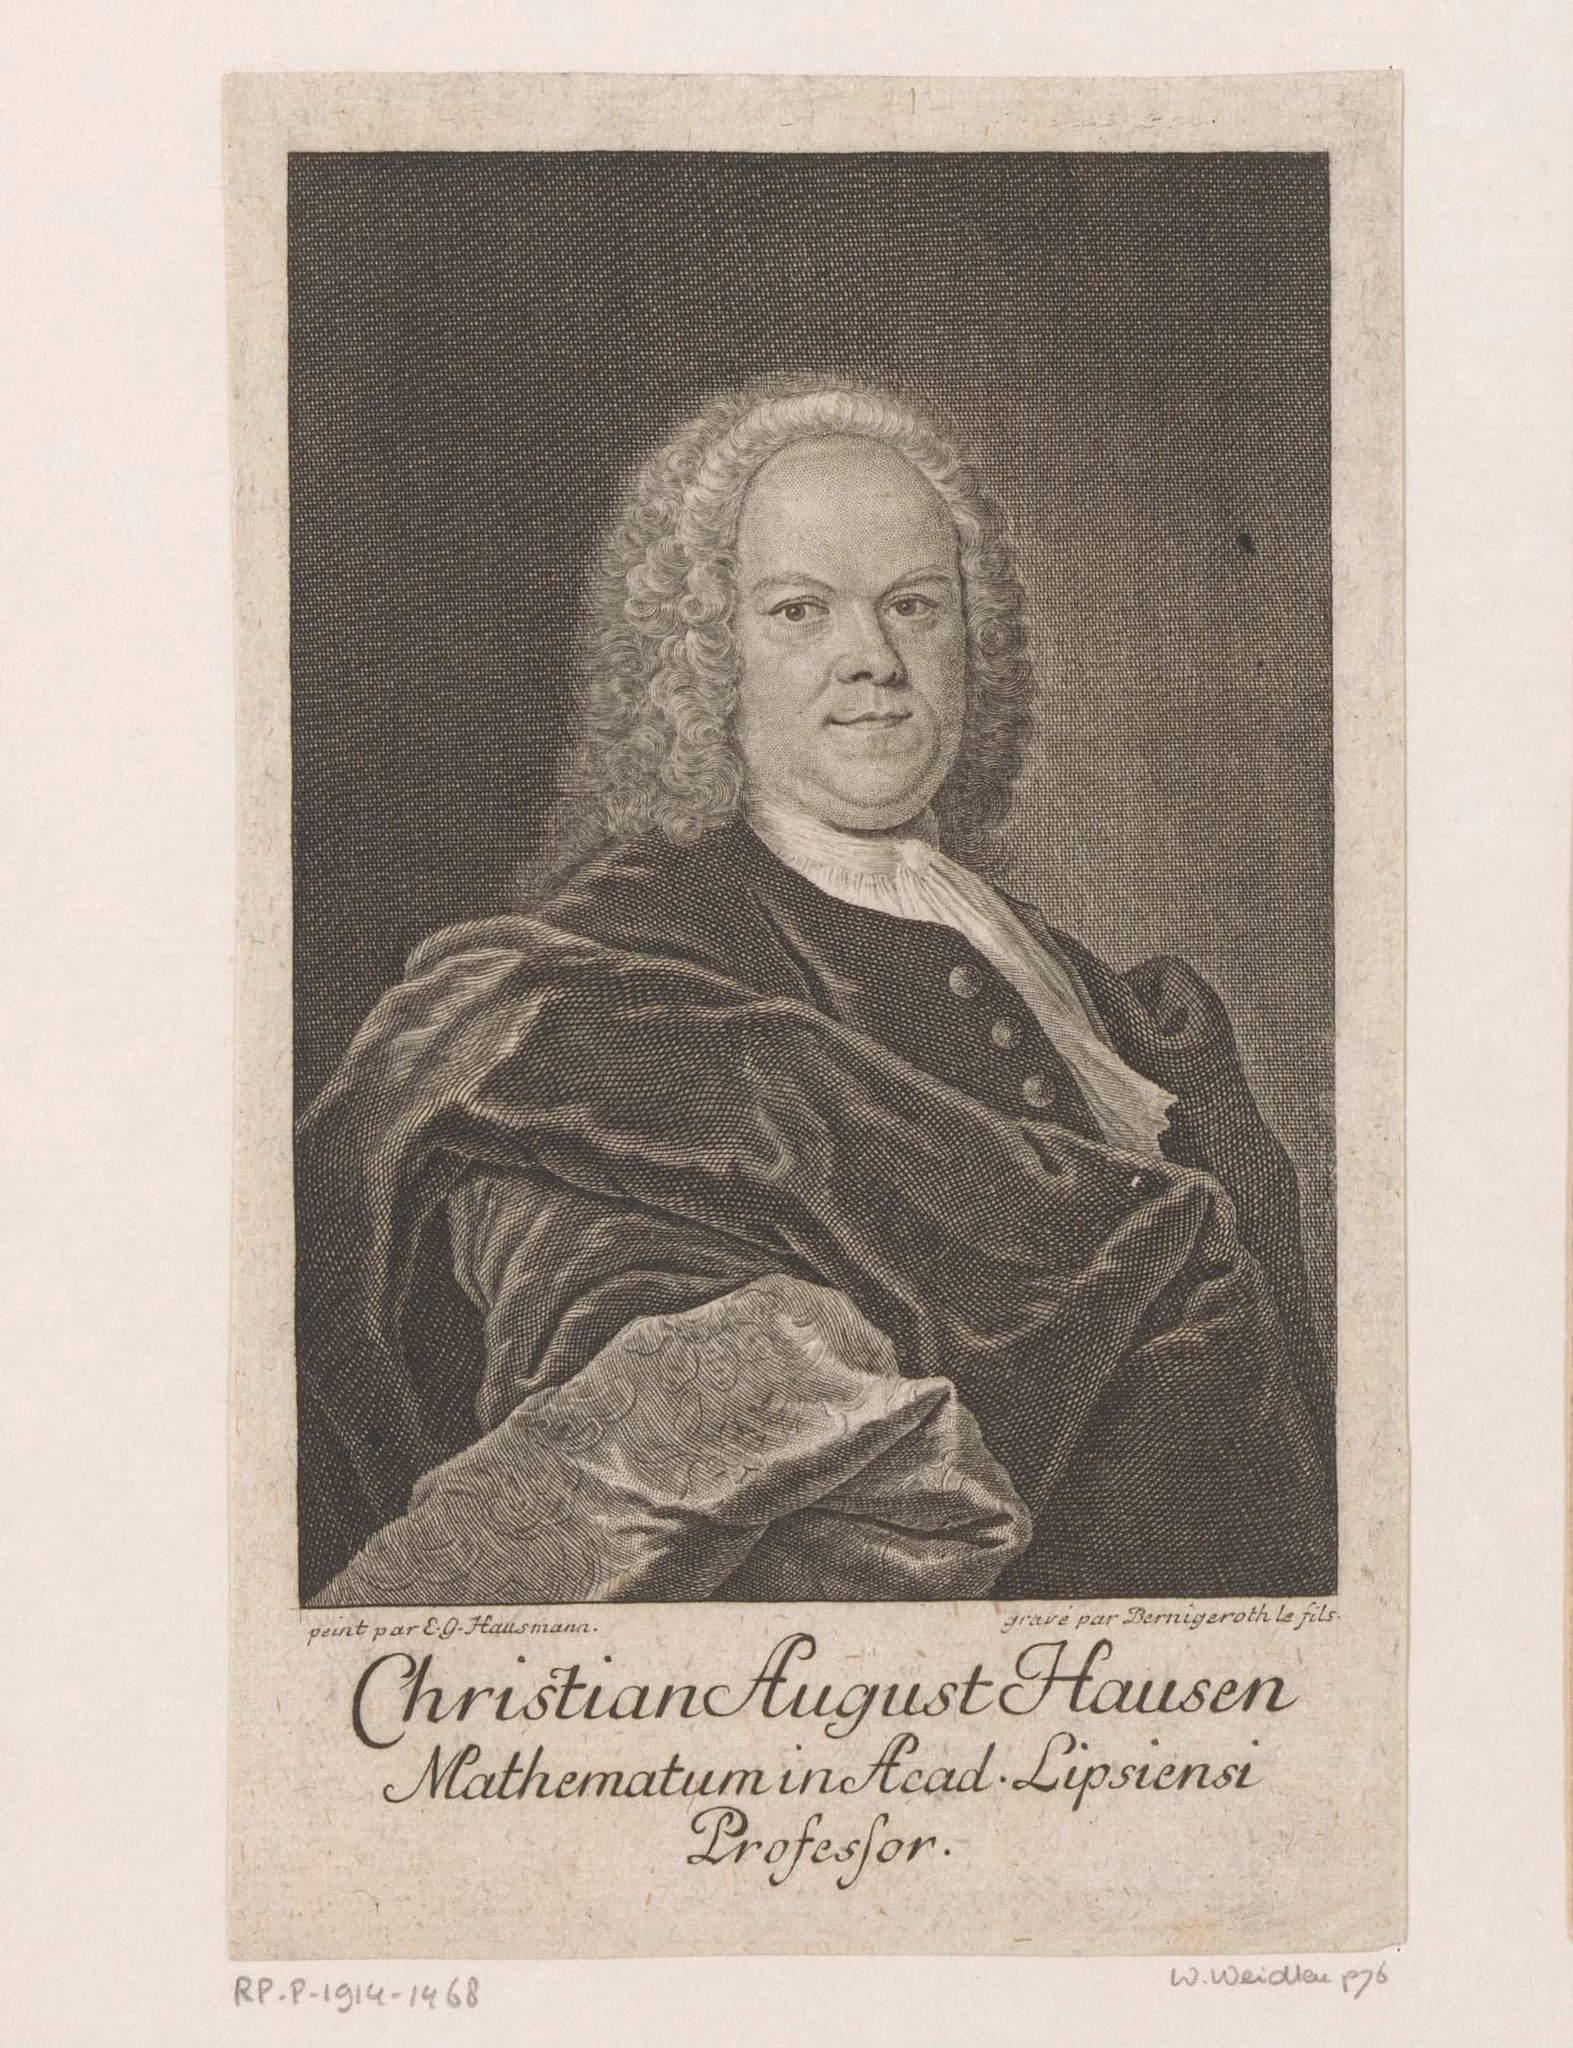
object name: print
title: Portret van Christian August Hausen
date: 1737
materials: paper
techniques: engraving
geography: leipzig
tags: historical persons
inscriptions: collector's mark: Lugt 2228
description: Prent ook gebruikt in: Deutsche Acta Eruditorum (...). dl. 215. Leipzig: Johann Gottlieb Gleditsch, 1737.